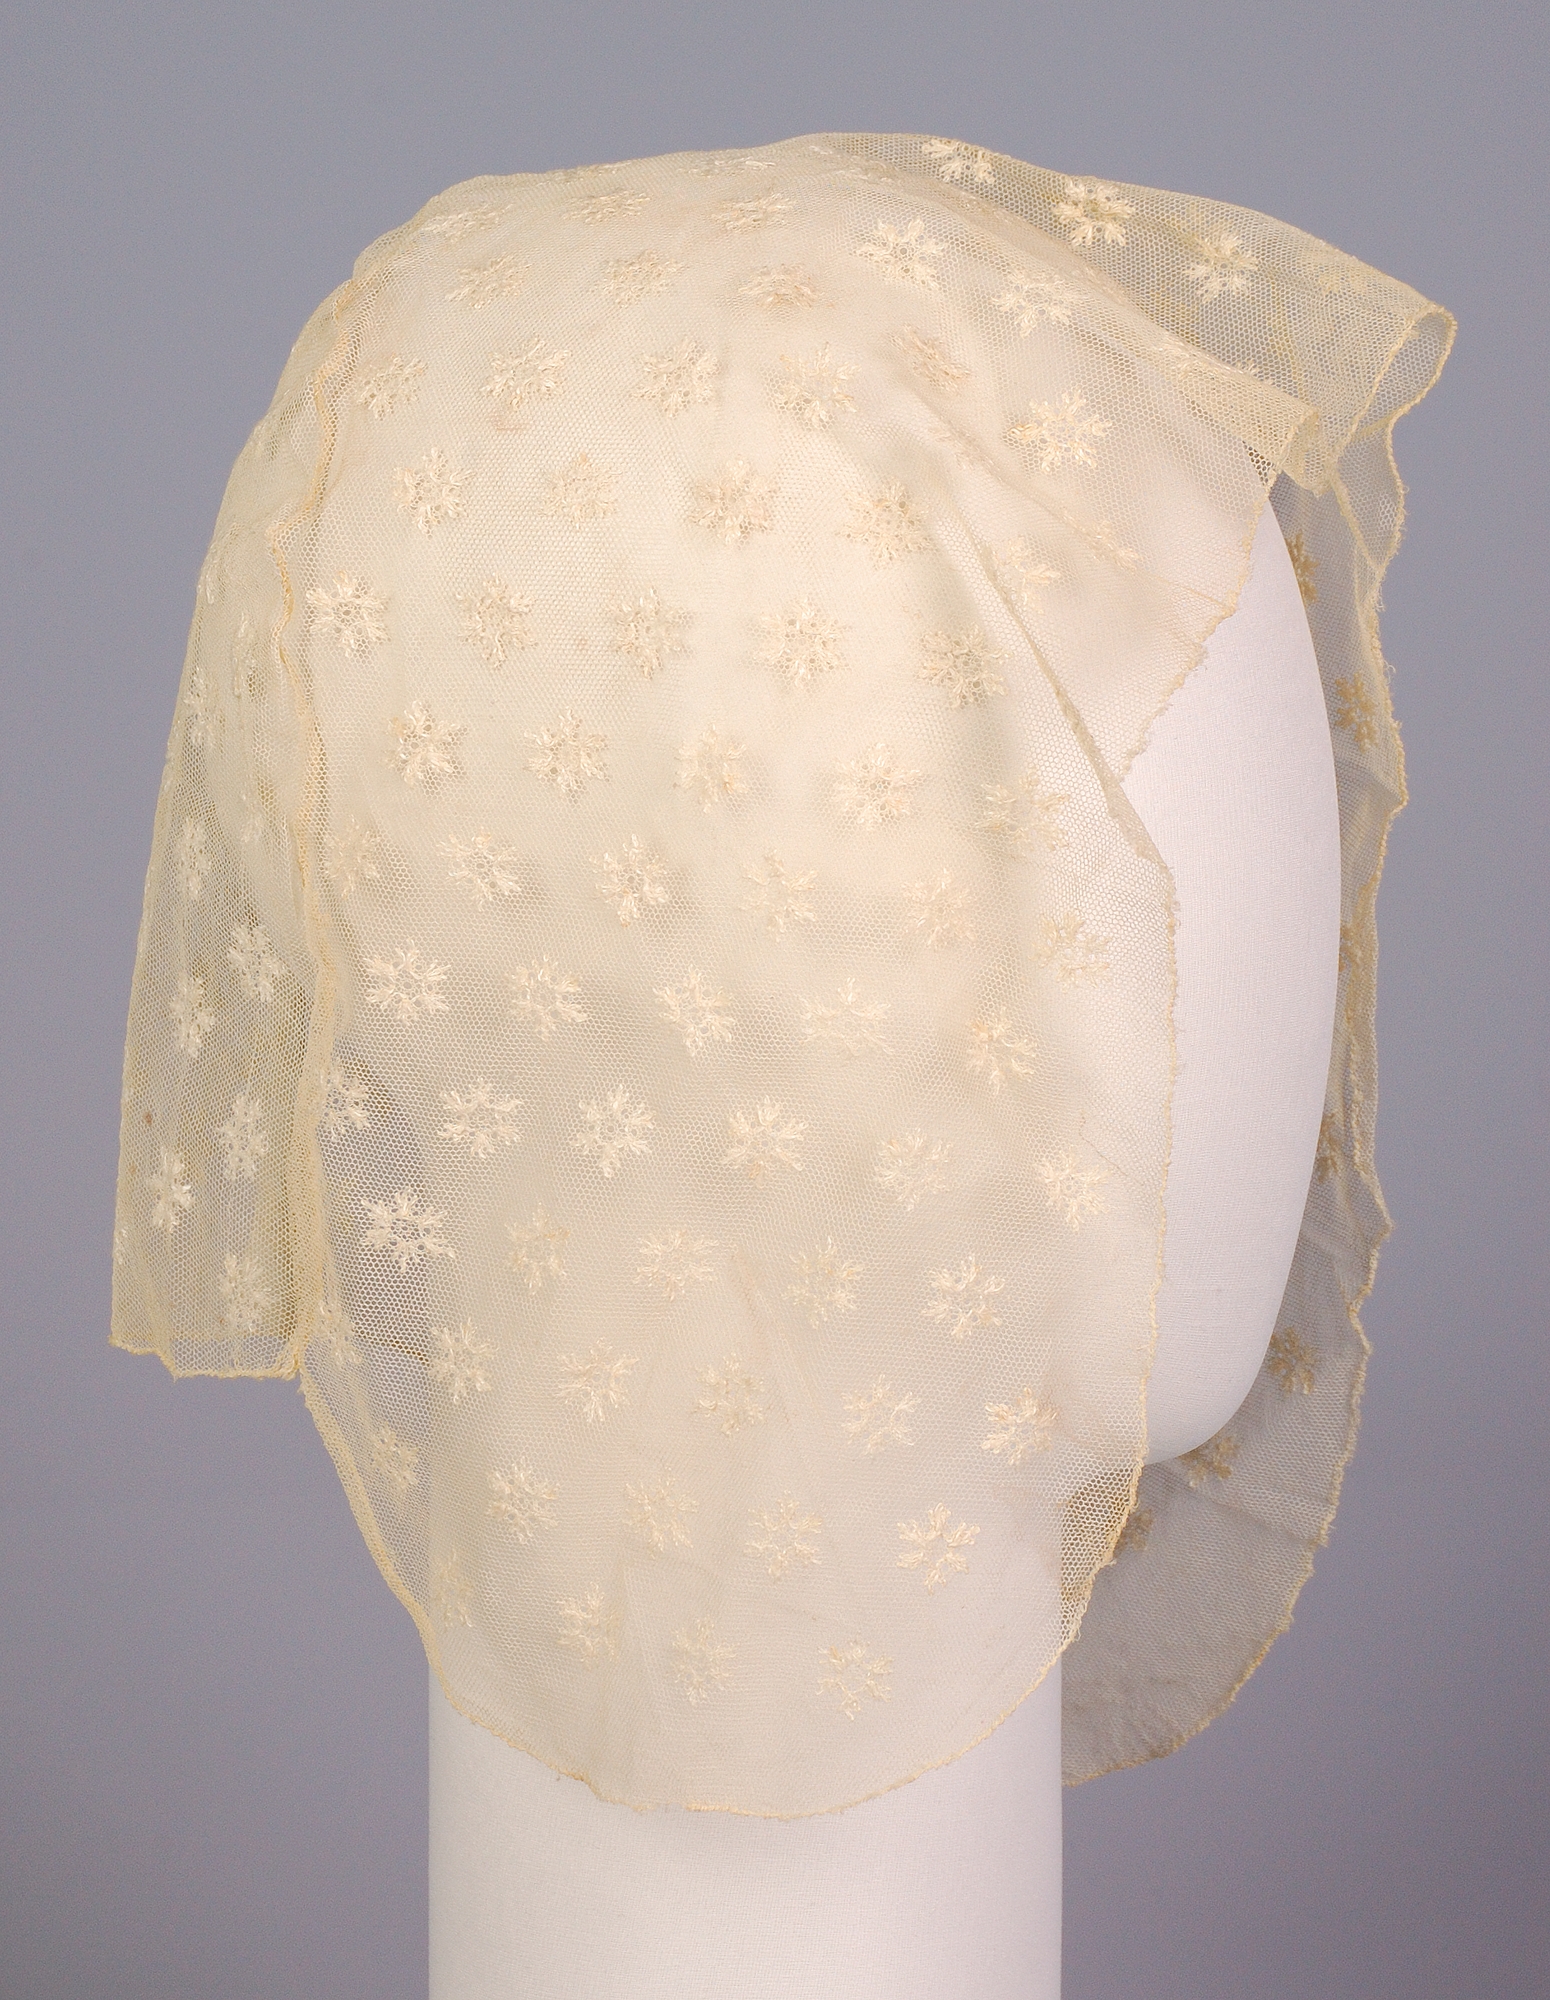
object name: cap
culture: american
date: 1840-1860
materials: silk